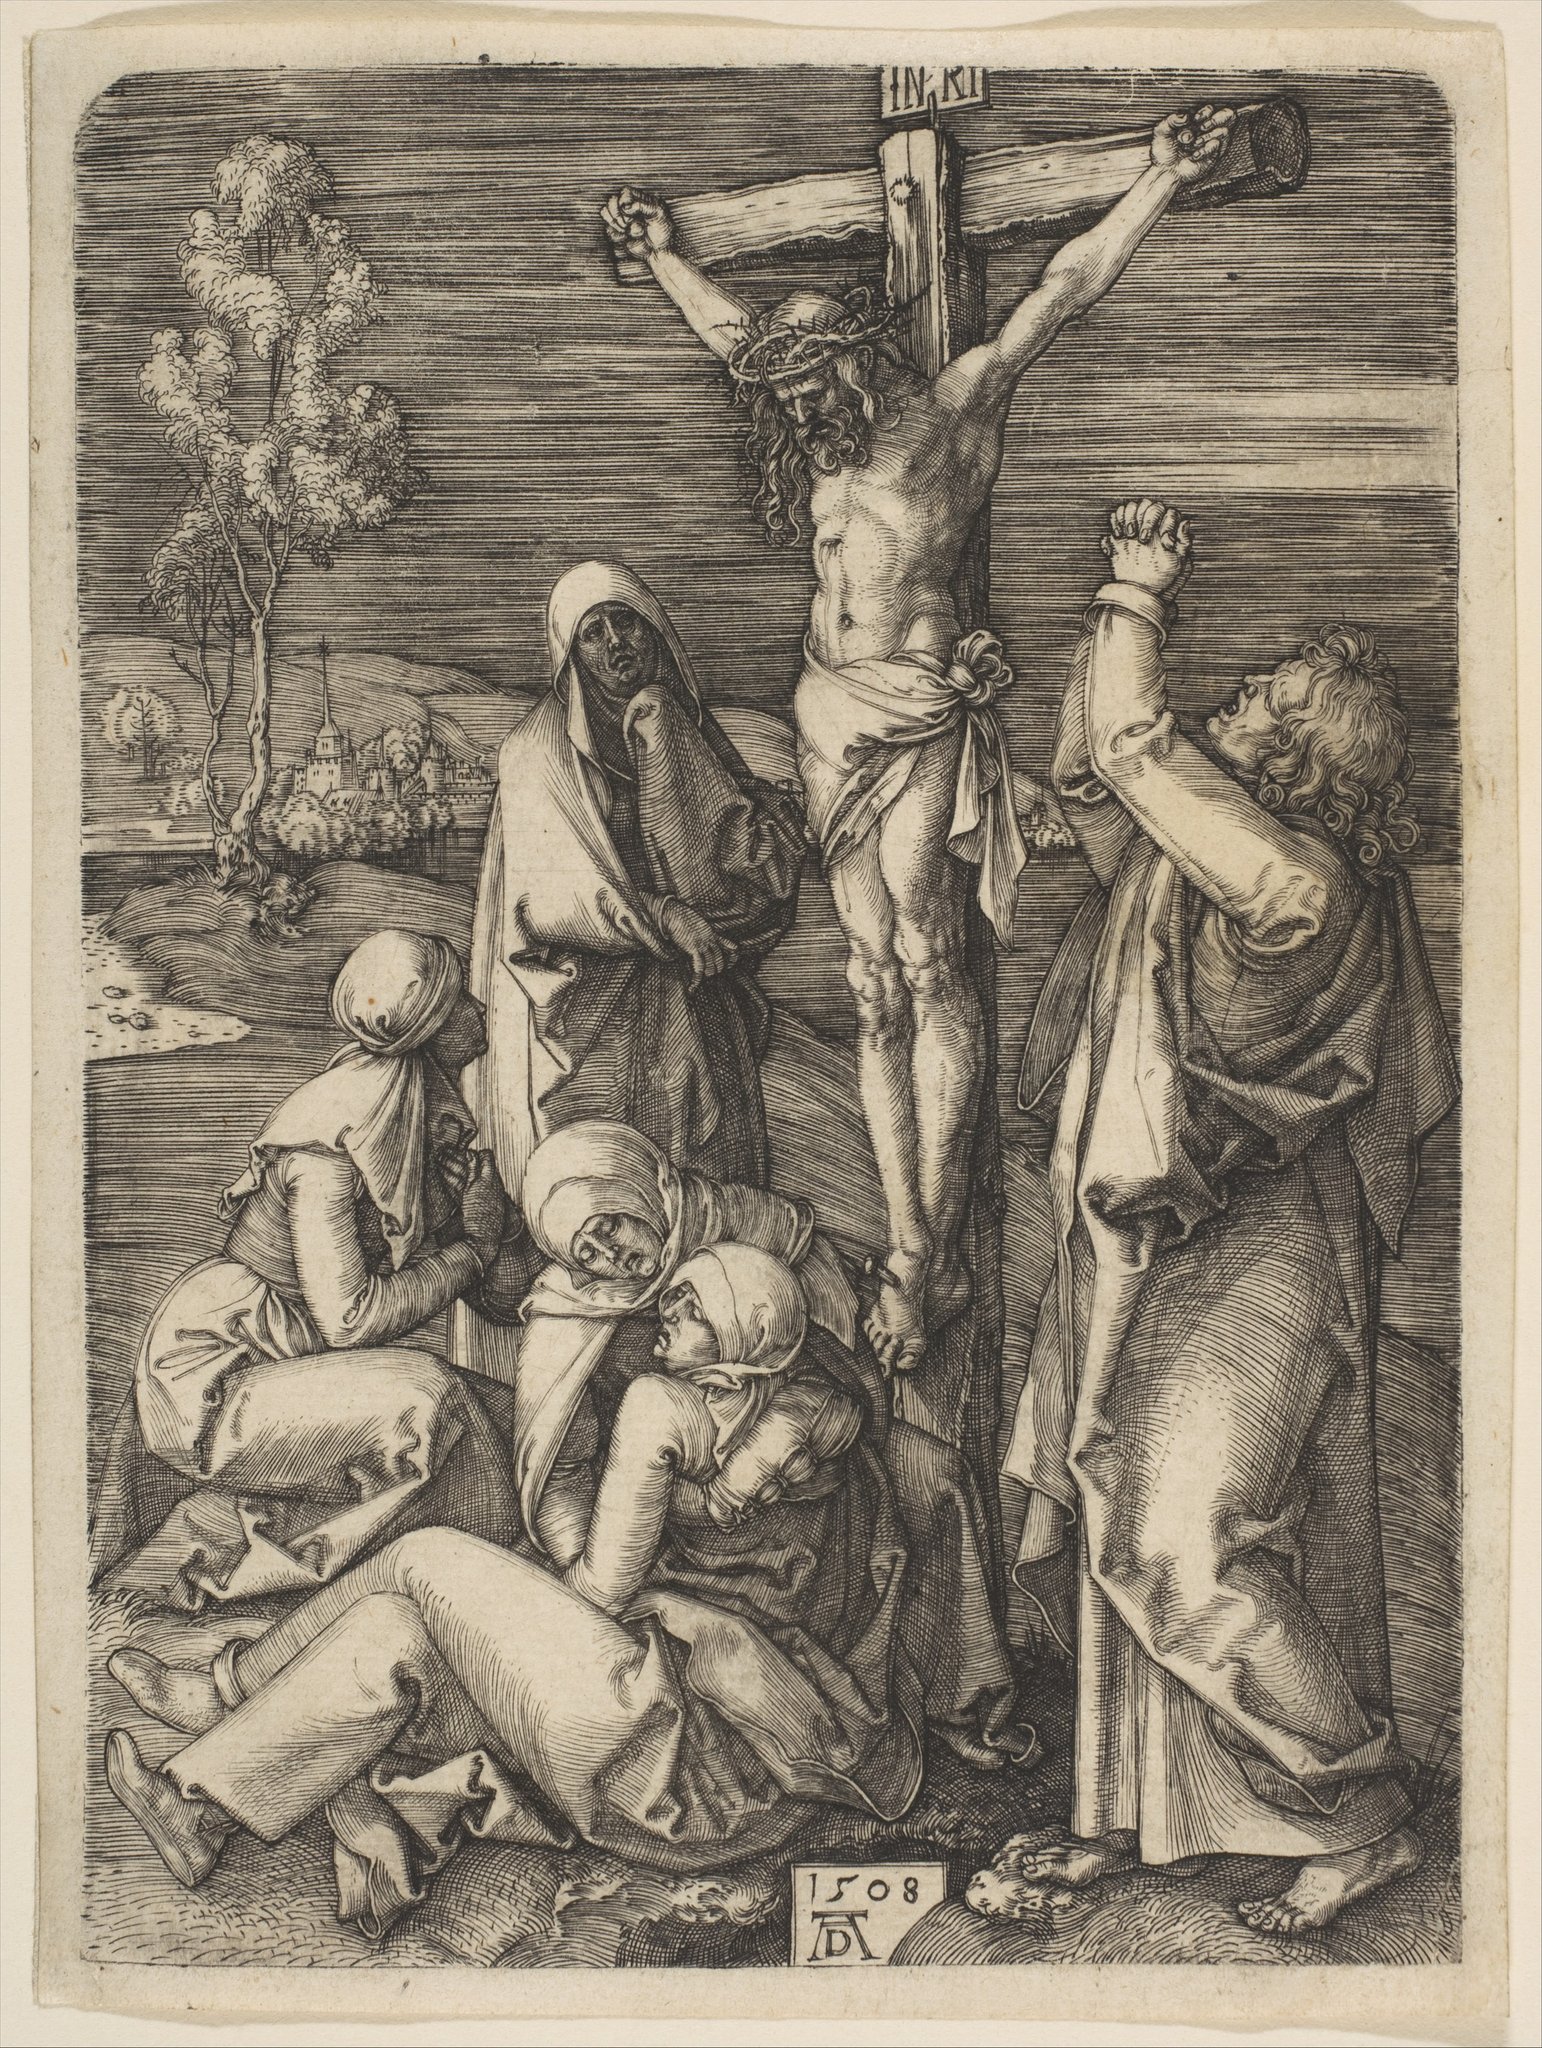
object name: print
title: Christ on the Cross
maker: albrecht dürer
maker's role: artist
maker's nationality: german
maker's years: 1471-1528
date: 1508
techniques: engraving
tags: men,women,christ,cross,crucifixion